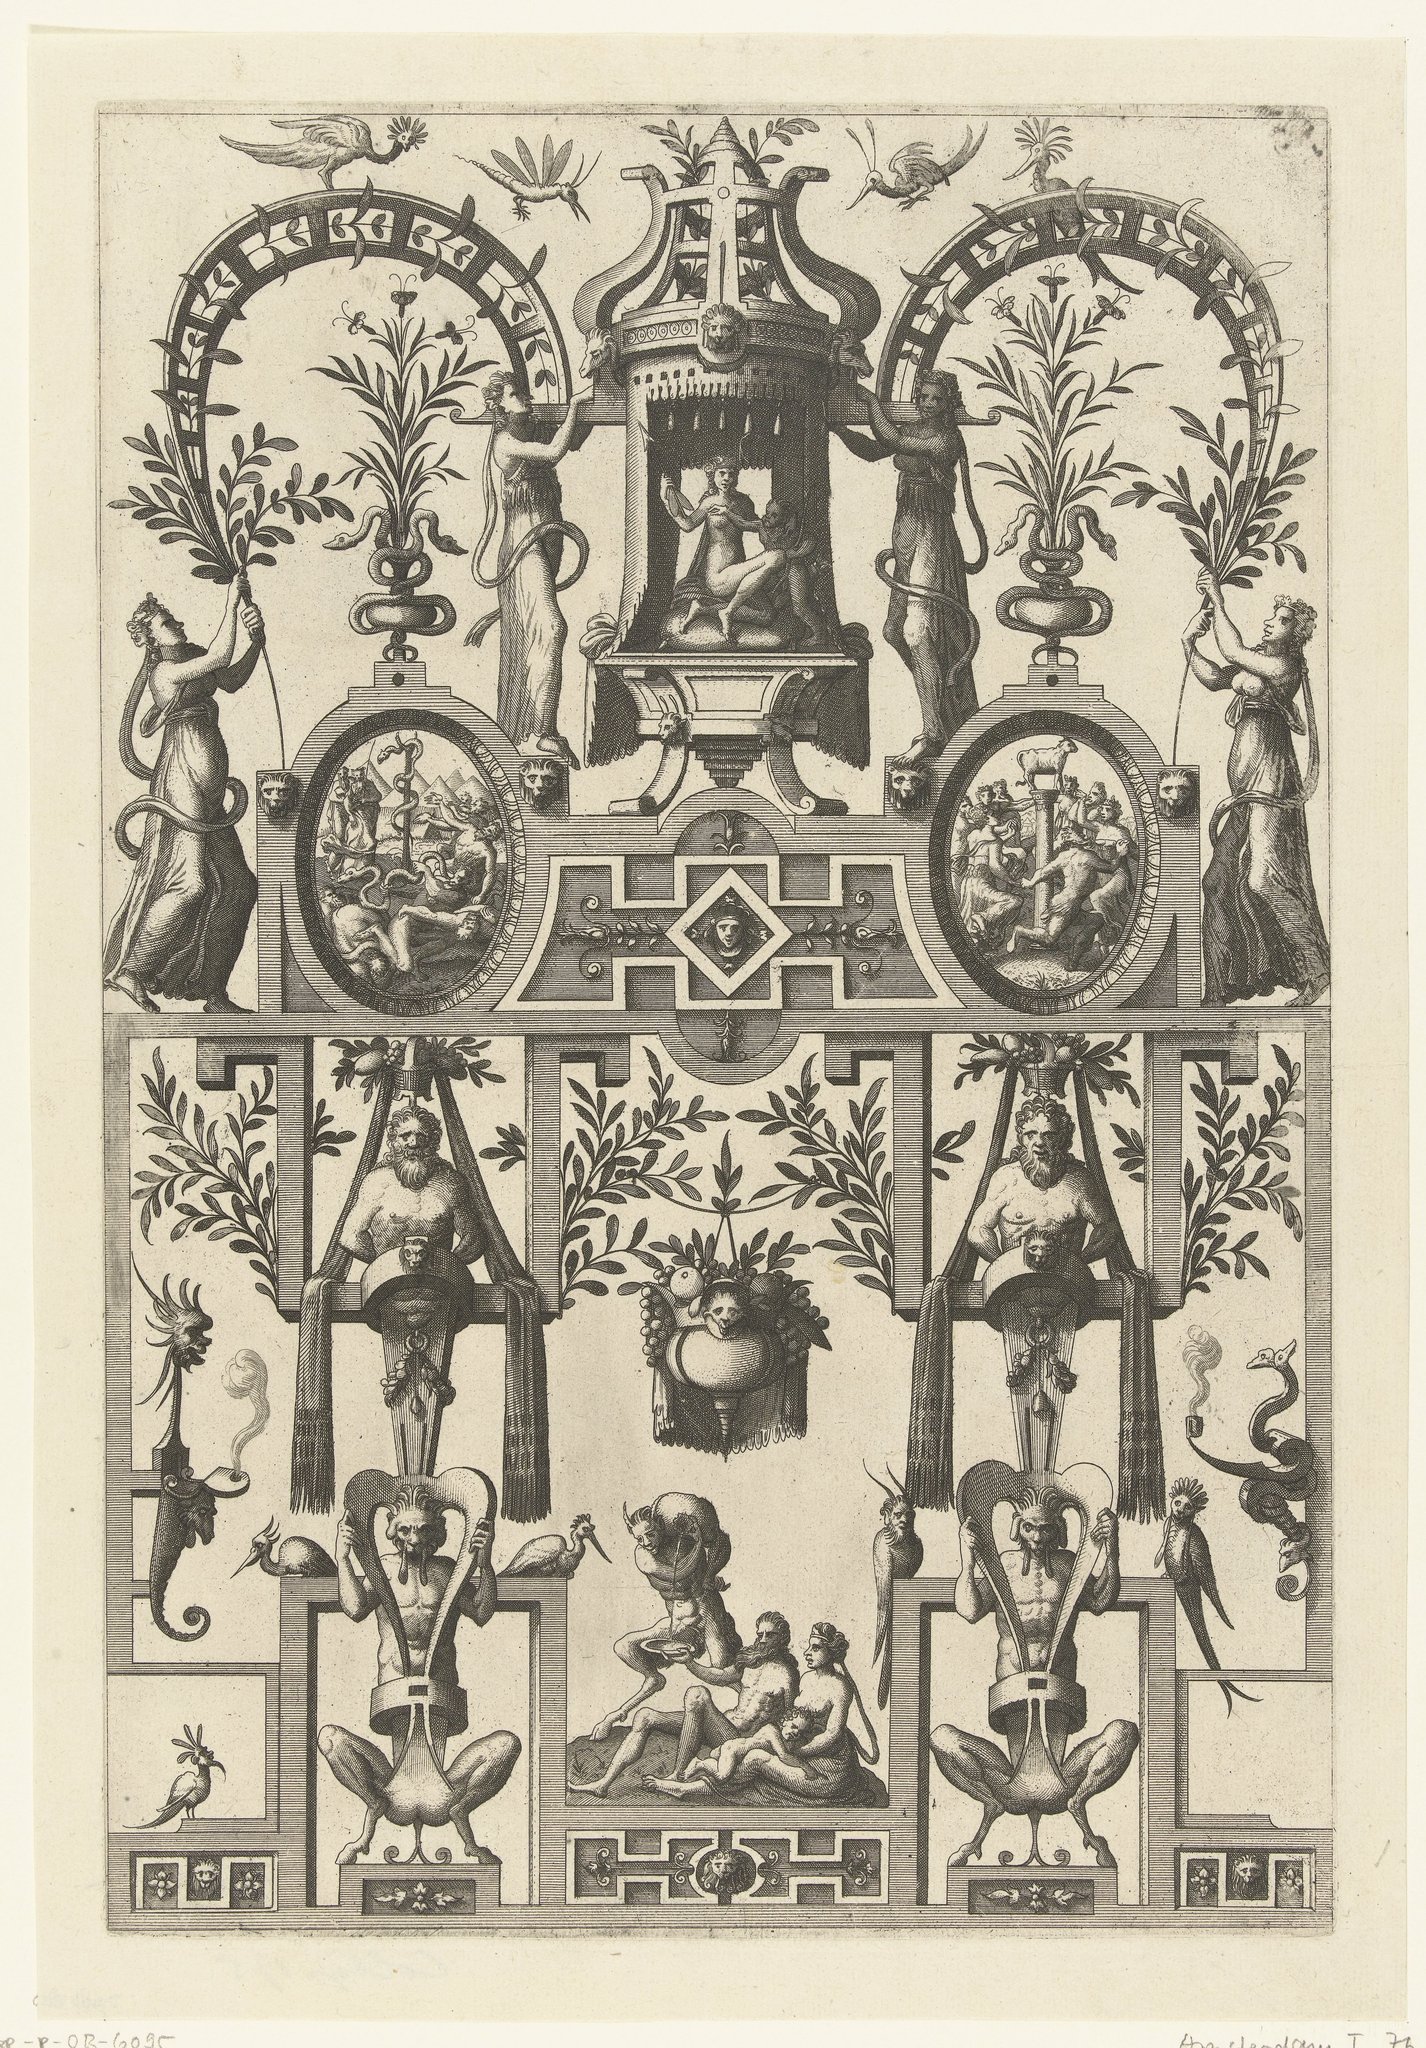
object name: print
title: Vlakdecoraties en grafmonumenten / Veelderleij niewe inventien (...)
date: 1557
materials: paper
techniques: etching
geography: netherlands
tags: ornaments ~ art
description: Middenonder zitten en man en vrouw met kind op de grond. Een stare schenkt hen wijn. Zij worden gefalnkeerd door gehurkte stares die elk een herme dragen. Daarboven een constructie waarin links en rechts een ovaal met voorstelling. Links de aanbidding van de koperen slang; rechts de aanbidding van het gouden kalf. Middenboven Venus en amor onder een baldakijn. Hoort bij serie bestaande uit een titelblad, een tekstblad en 14 bladen met grotesken met rolwerk, saters, guirlandes, trofeeën, dieren en fantasiewezens.